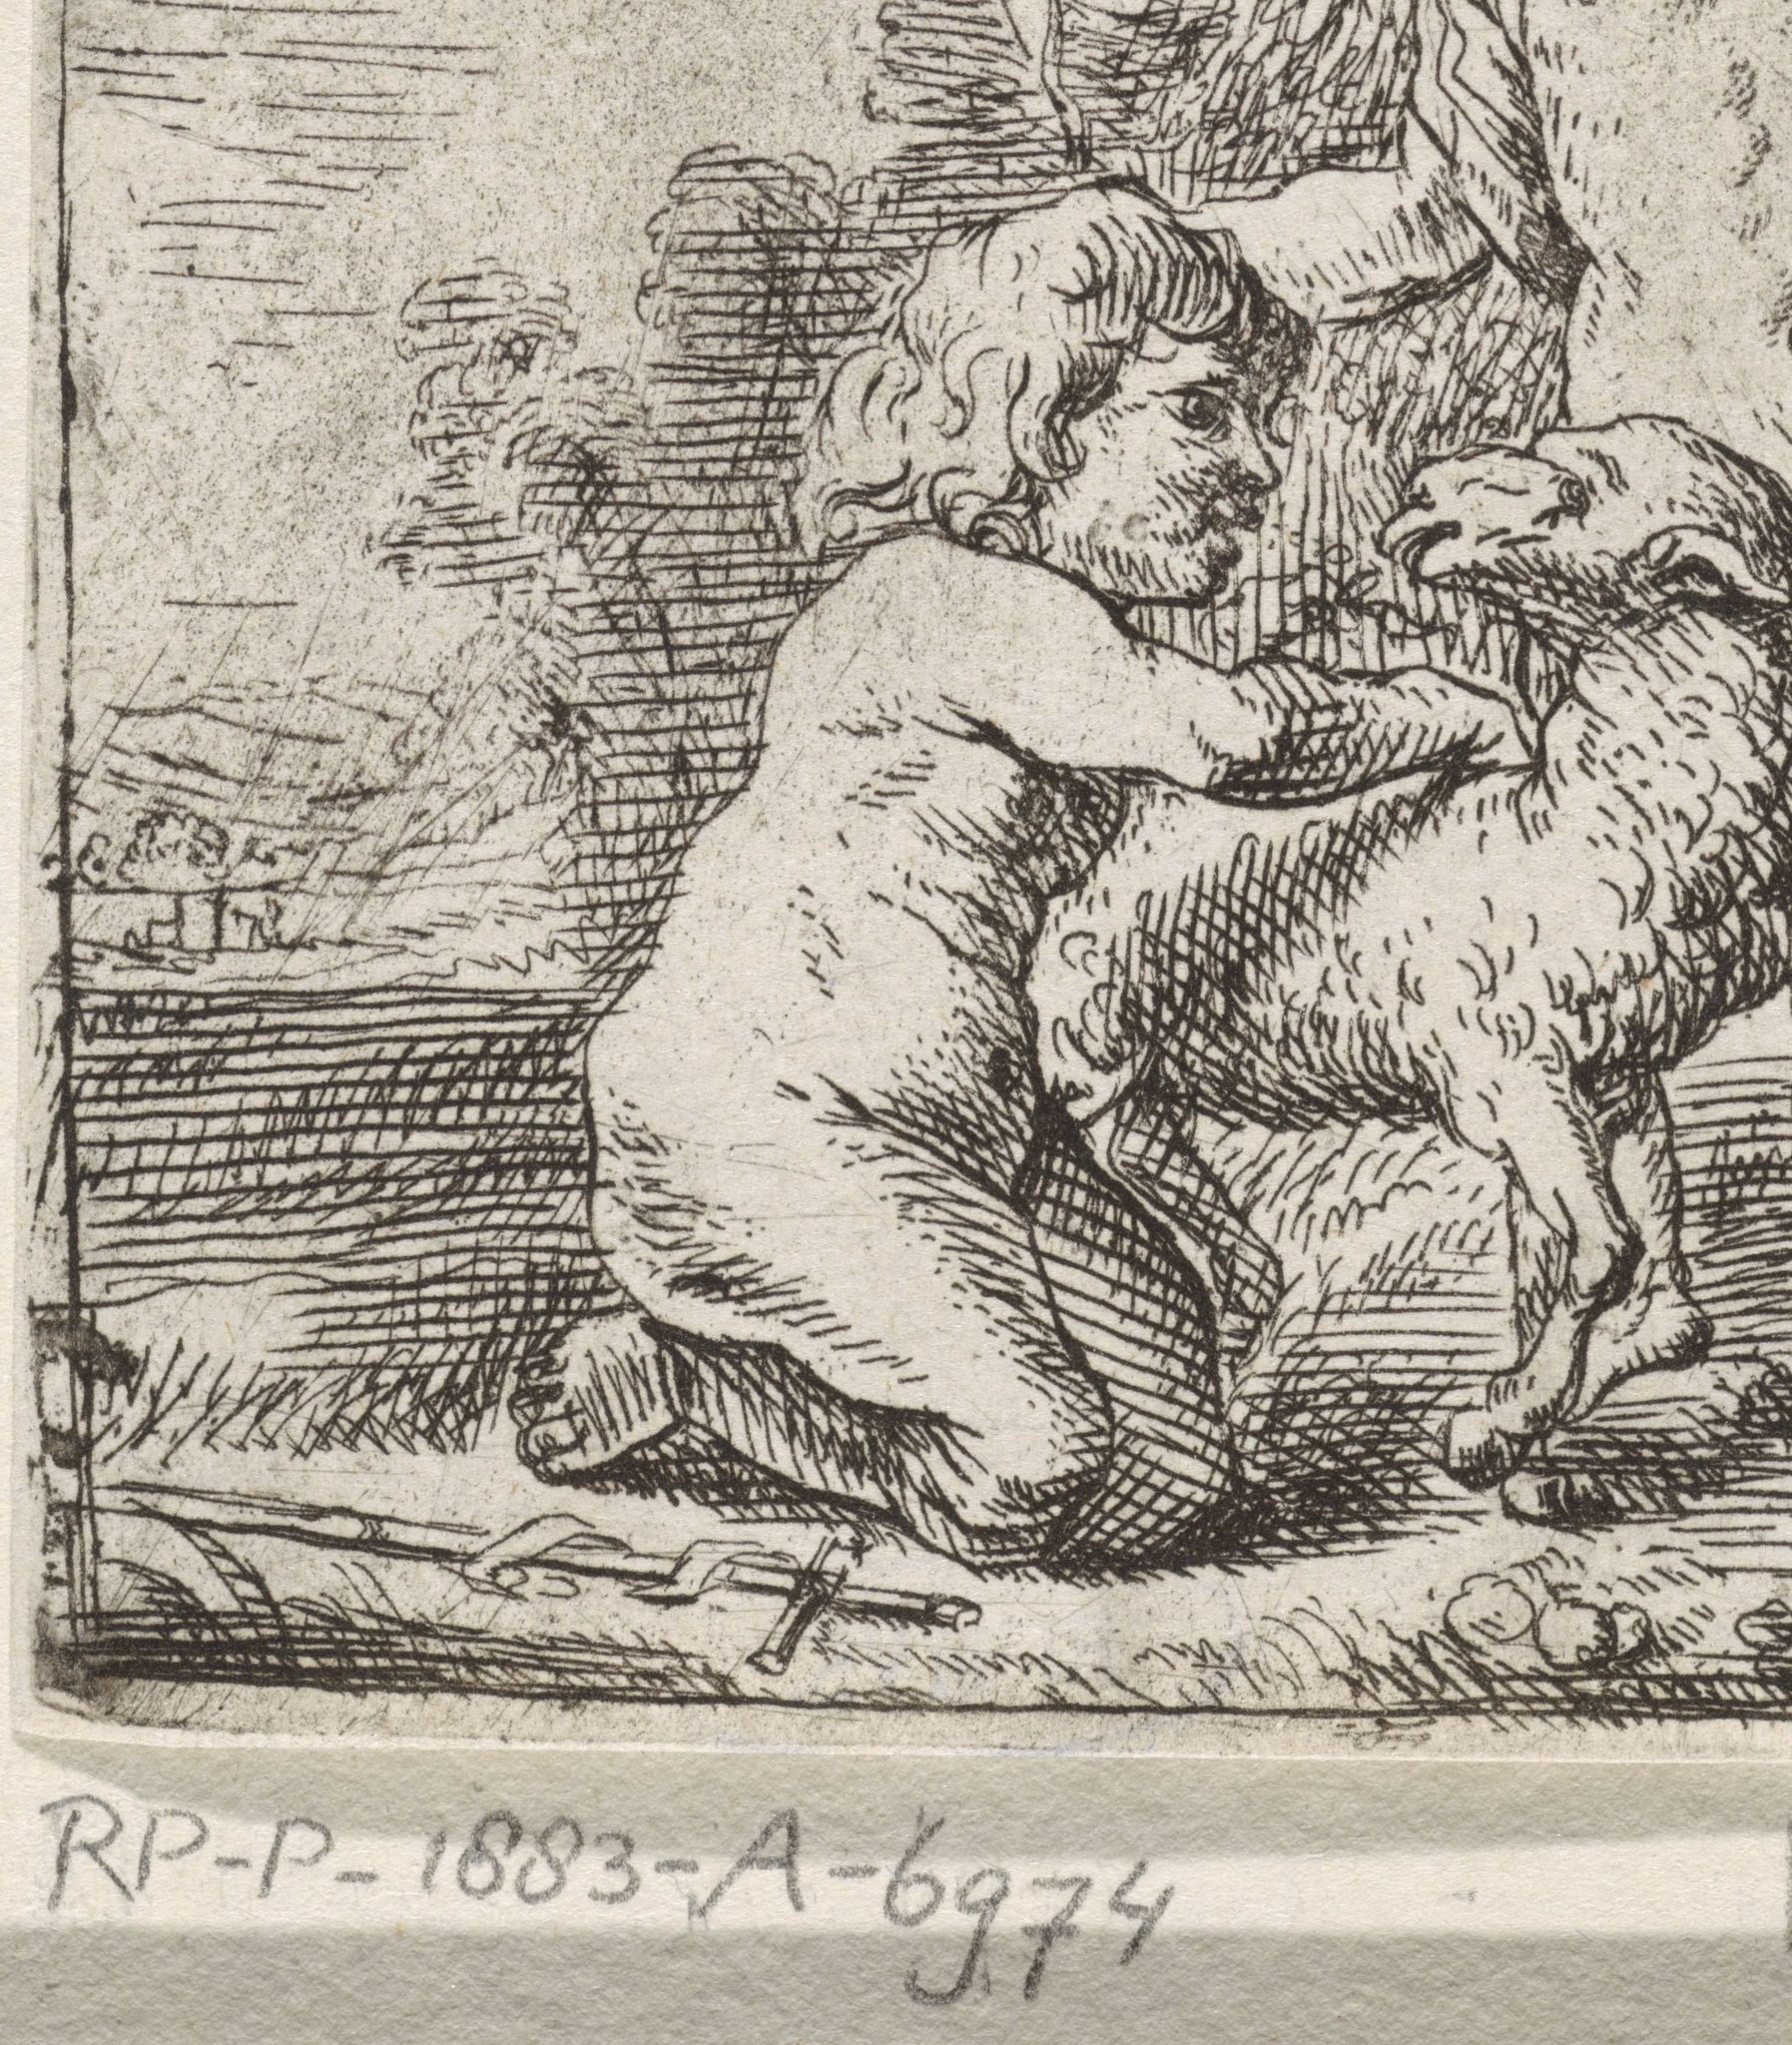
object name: print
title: Christuskind en Johannes de Doper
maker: cornelis schut (i)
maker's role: draughtsman, print maker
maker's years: 1597-1655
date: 1618-1655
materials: paper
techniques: etching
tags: the christ-child and john the baptist (as child)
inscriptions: collector's mark: Lugt 2228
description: De jonge Johannes de Doper zit op zijn knieën en aait een lam. Het Christuskind staat er achter in zegenende houding.